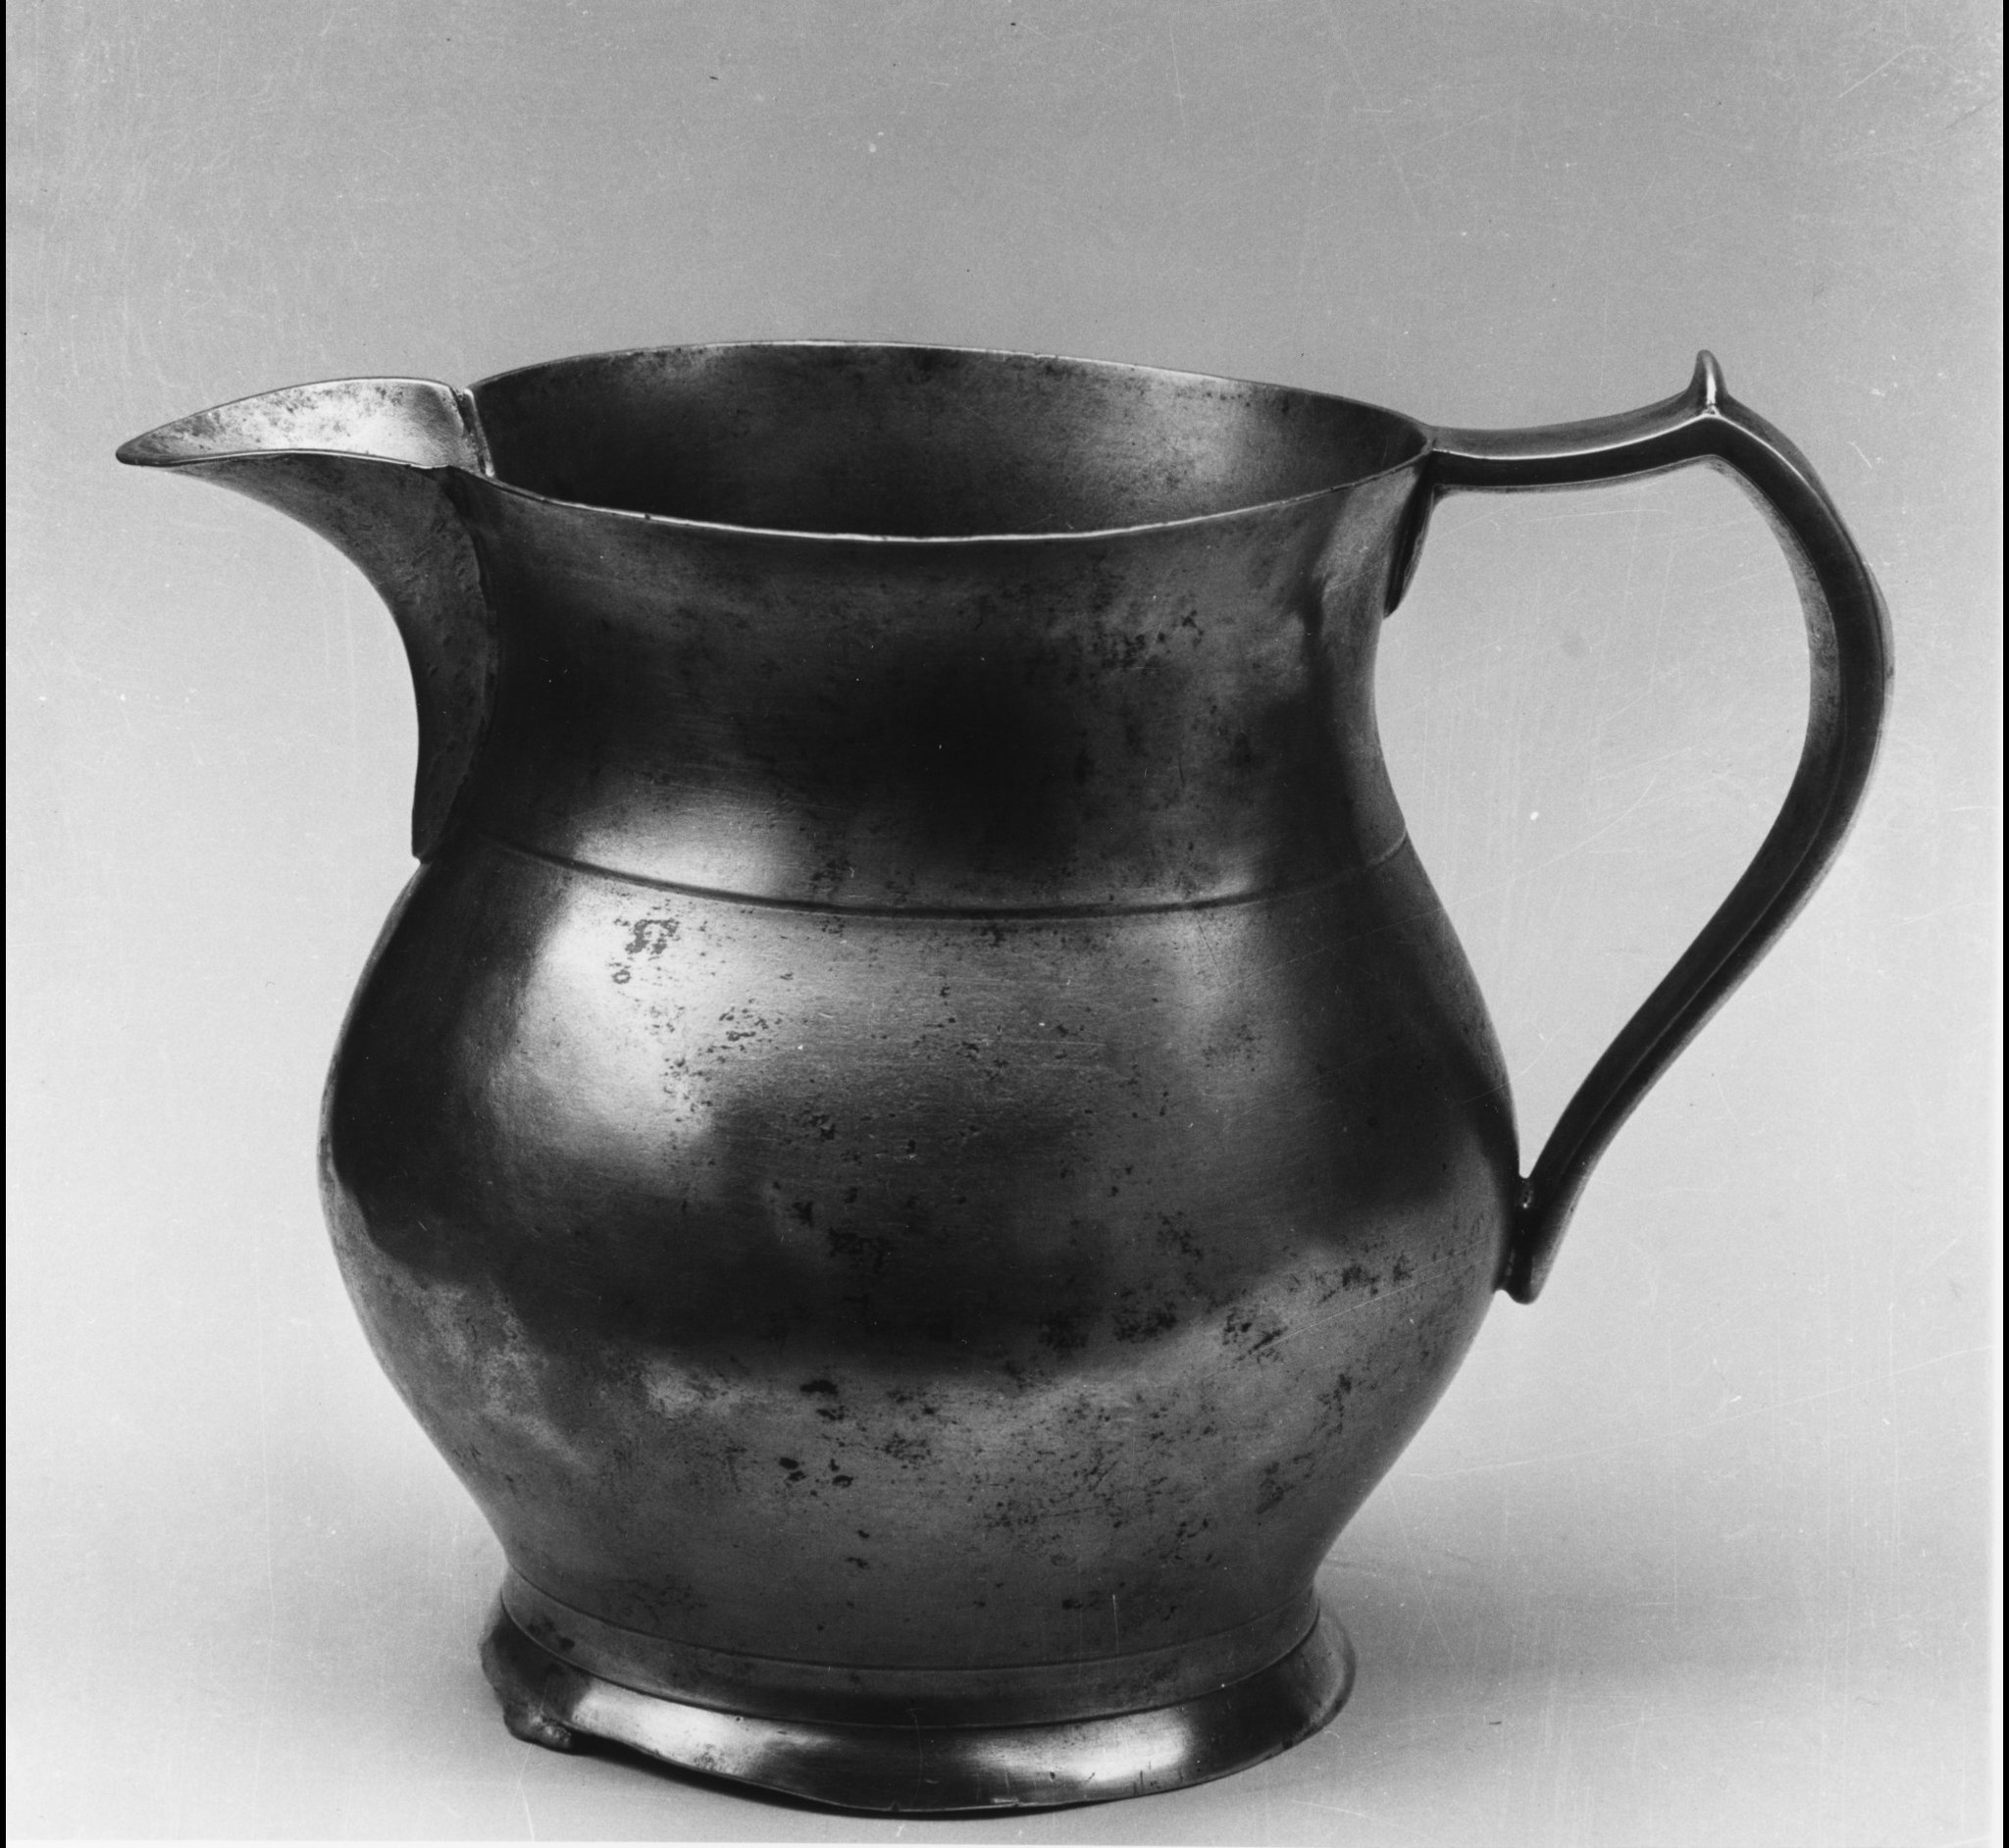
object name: pitcher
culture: american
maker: freeman porter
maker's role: maker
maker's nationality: american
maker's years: 1808-1869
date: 1835-1860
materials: pewter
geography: united states